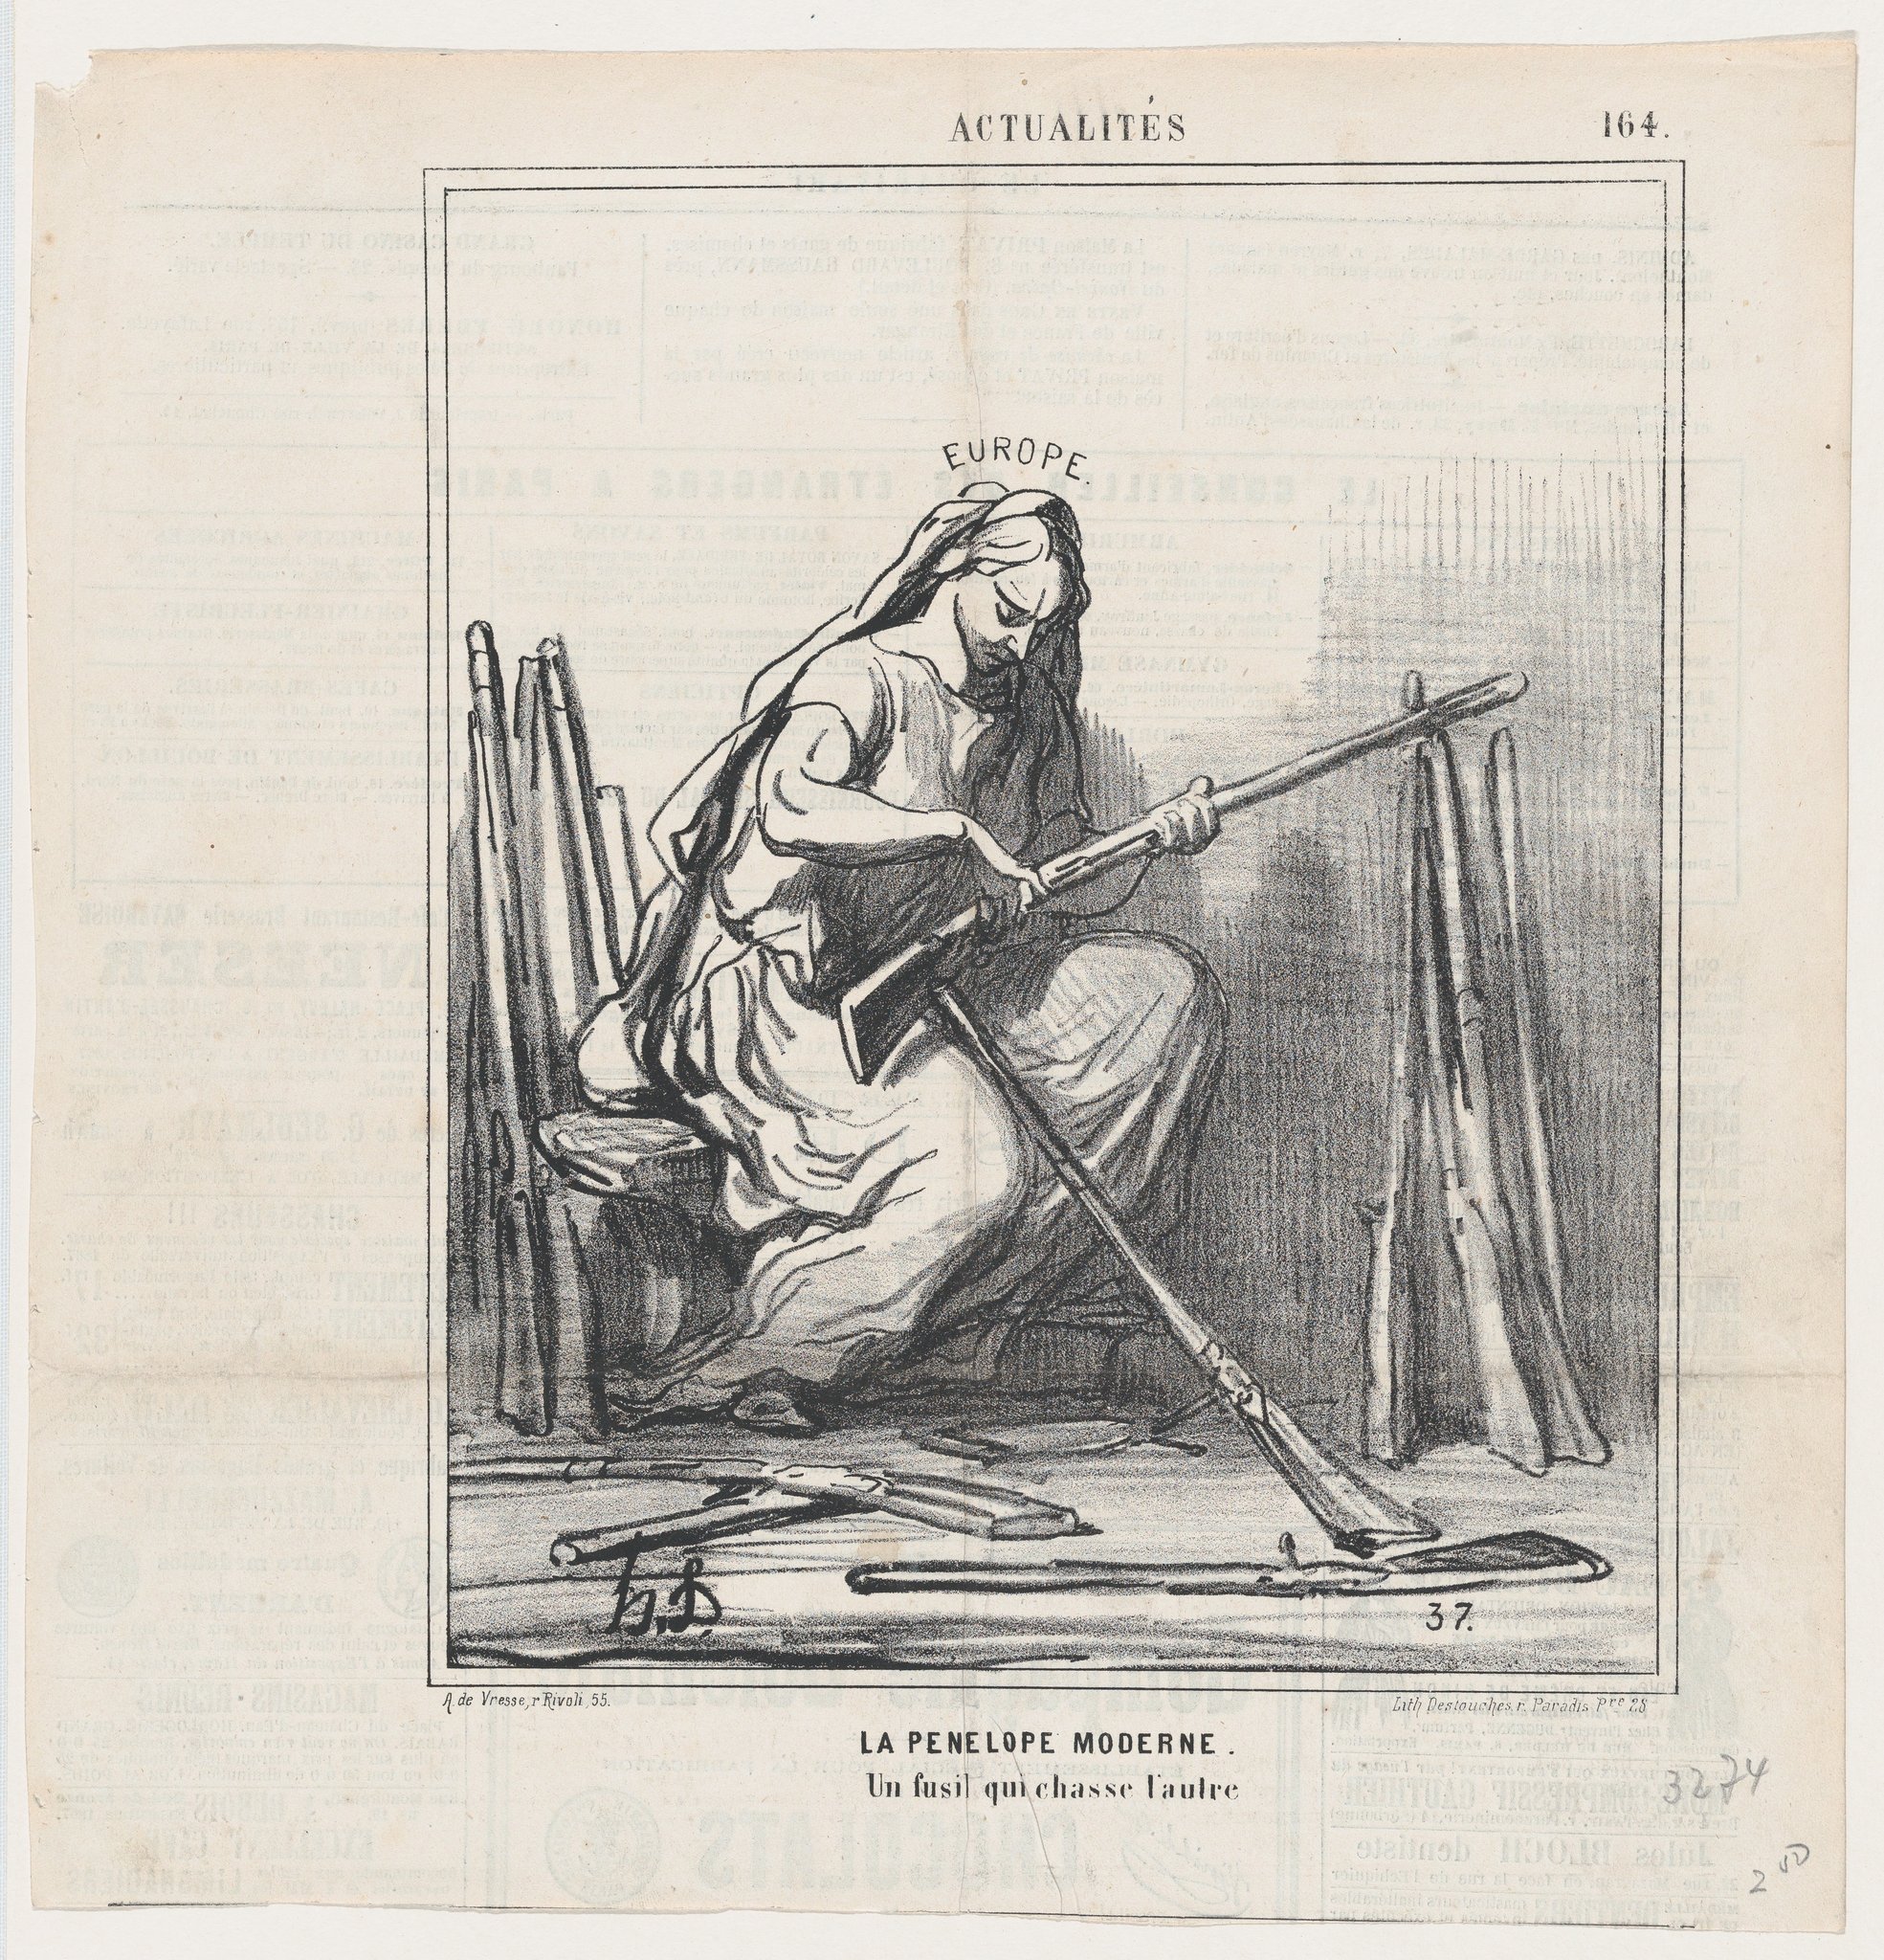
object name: print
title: Modern Penelope: one gun after another, from 'News of the day,' published in "Le Charivari"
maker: honoré daumier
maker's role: artist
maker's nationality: french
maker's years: 1808-1879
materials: paper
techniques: lithograph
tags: firearms,women